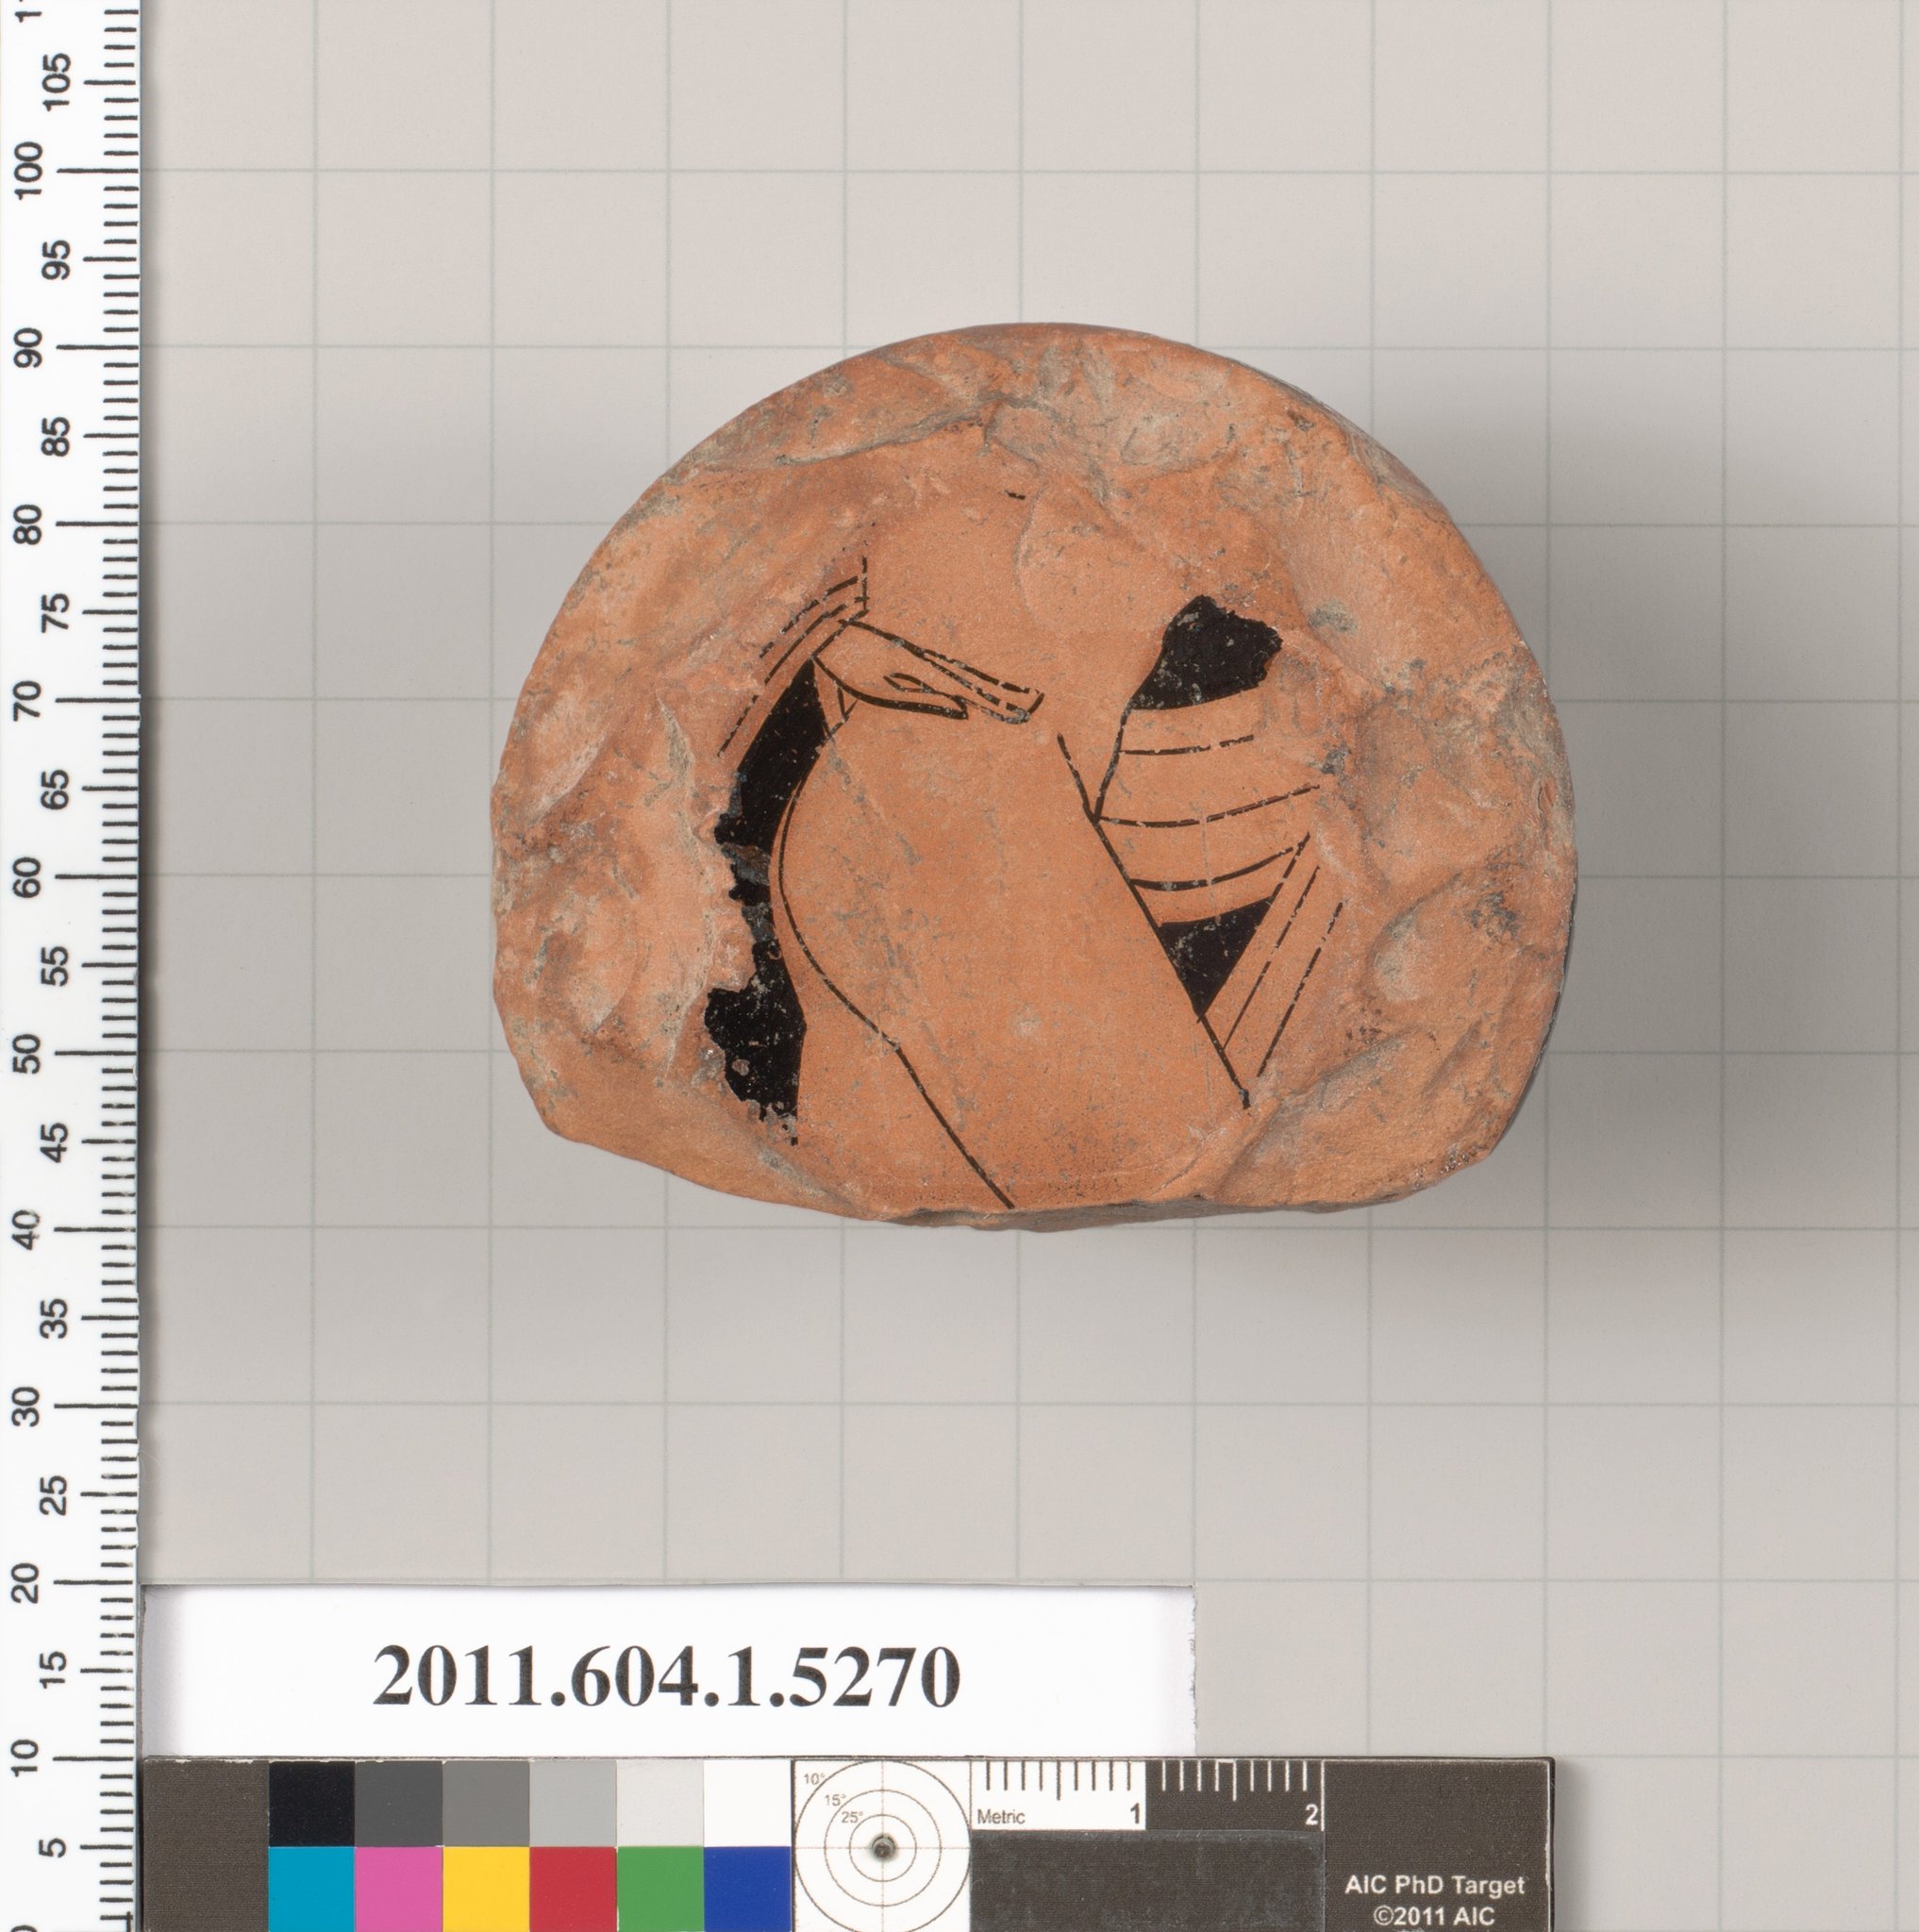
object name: kylix fragment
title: Terracotta fragment of a kylix (drinking cup)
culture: greek, attic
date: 520-510 BCE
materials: terracotta